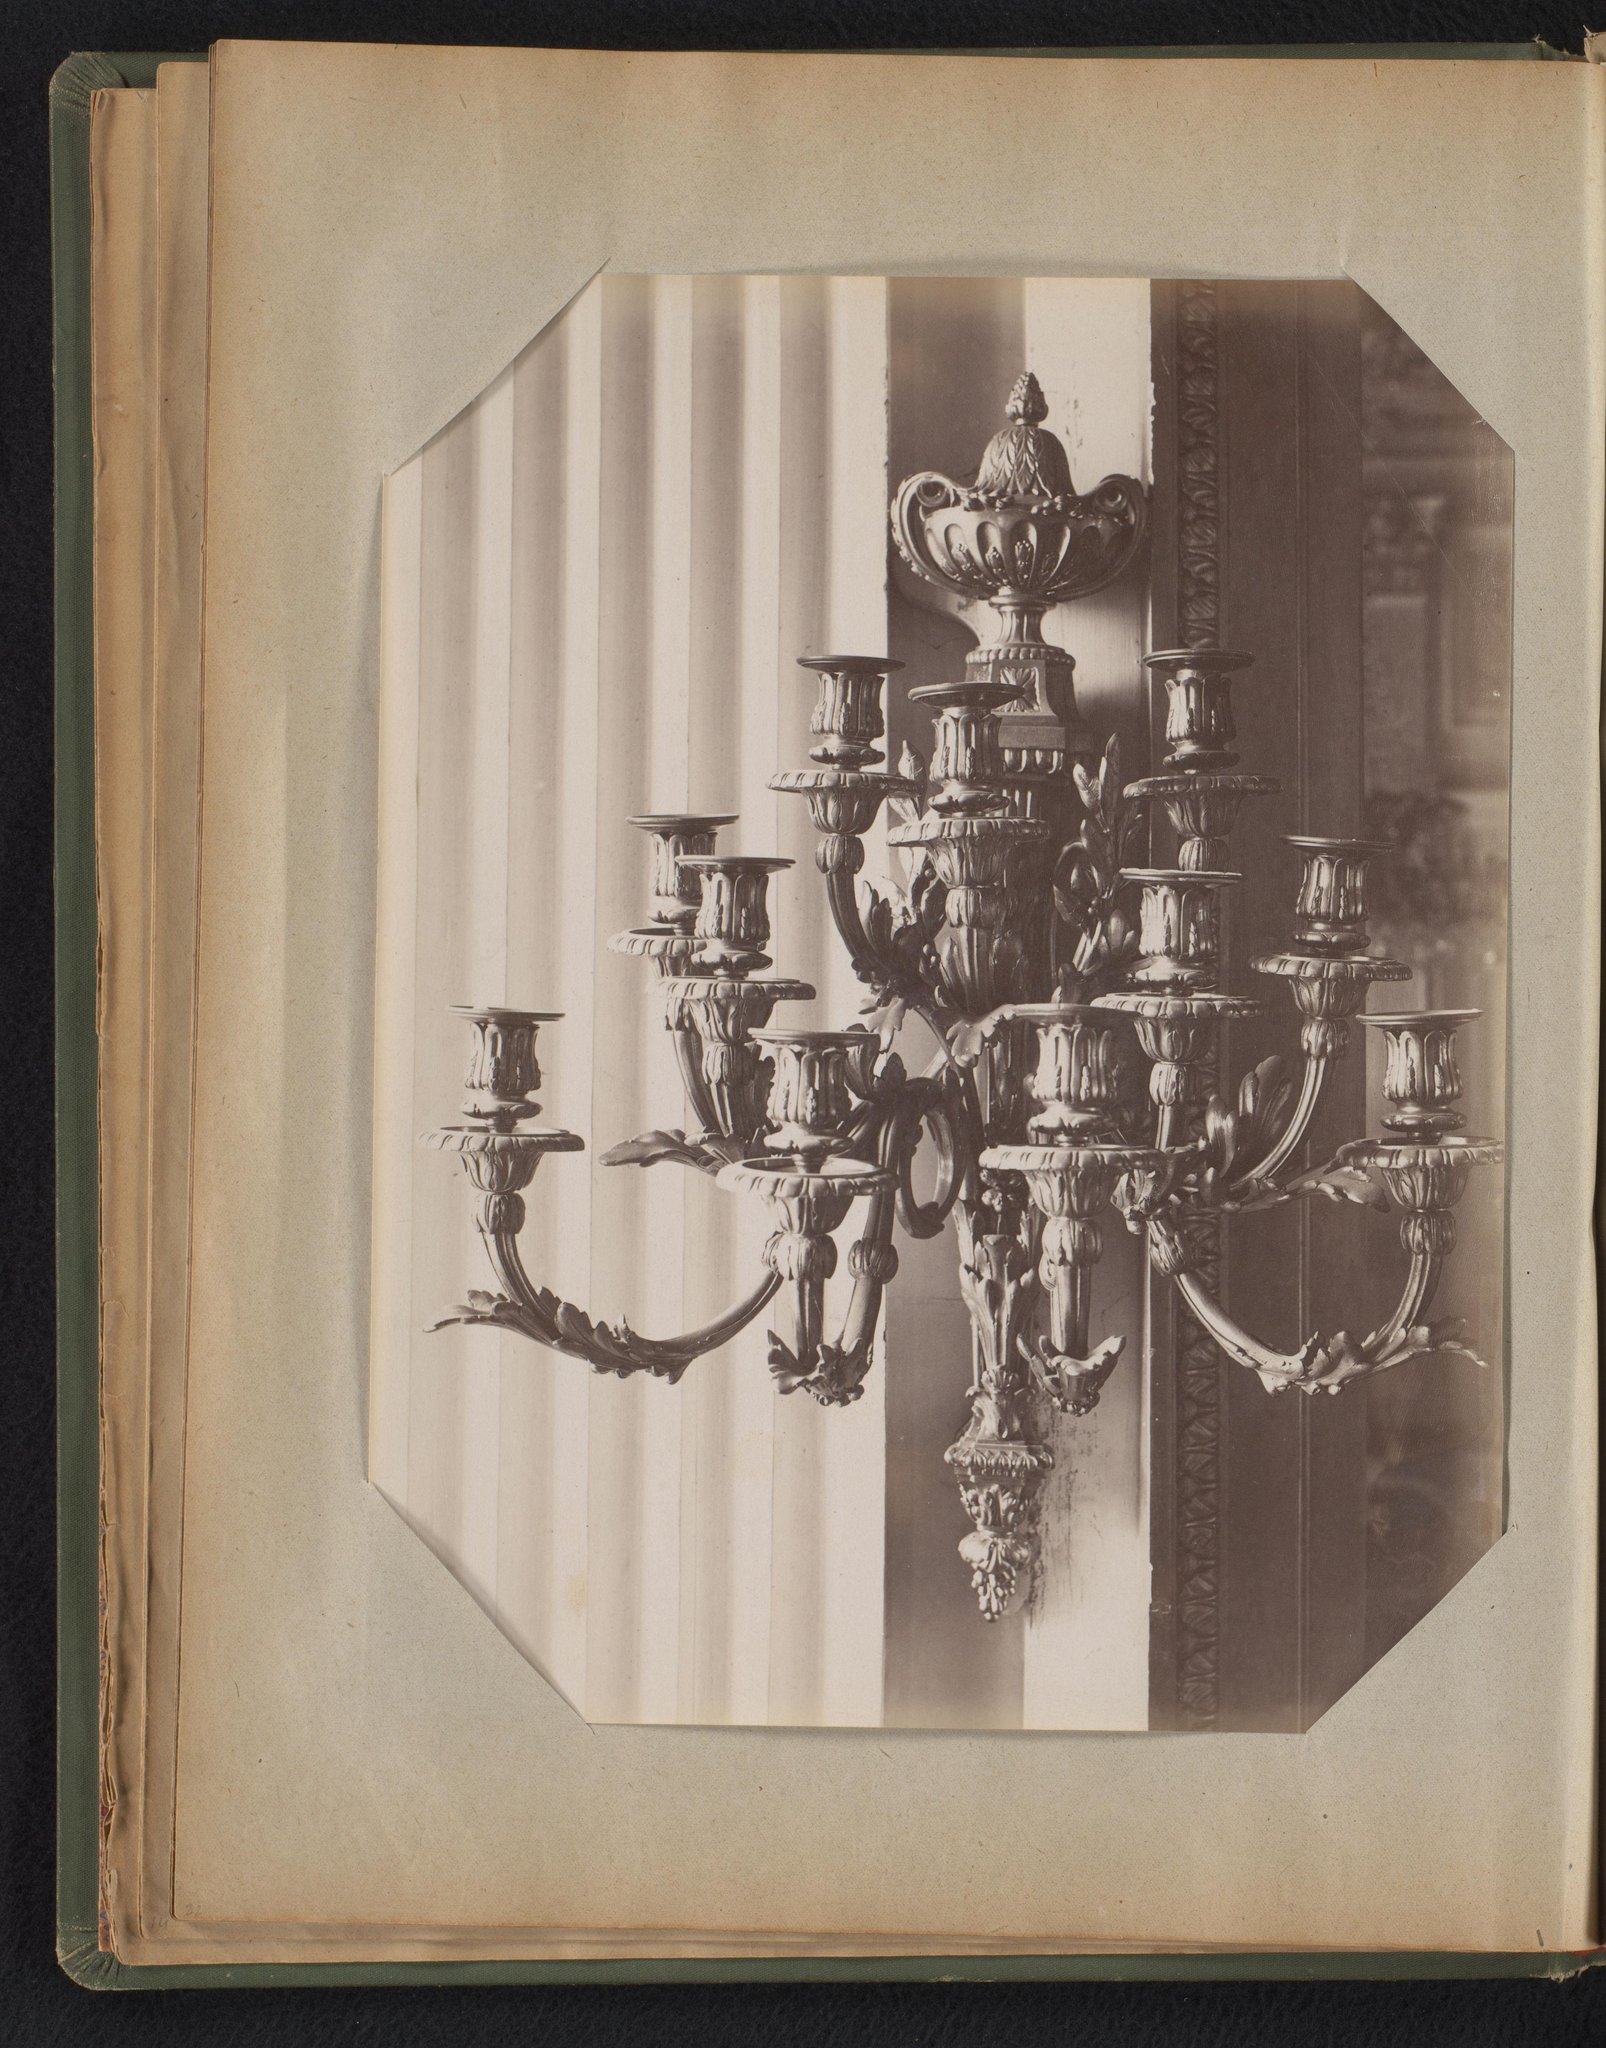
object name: photograph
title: Bronzen tien armige wandkandelaar voorzien van ornamenten met bovenop een bokaal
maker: Anonymous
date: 1860-1900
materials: canvas, cardboard, paper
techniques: albumen print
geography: netherlands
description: Onderdeel van een serie met betrekking tot het interieur van het paleis van Versailles met kroonluchters, deuren, portalen en meubelstukken.